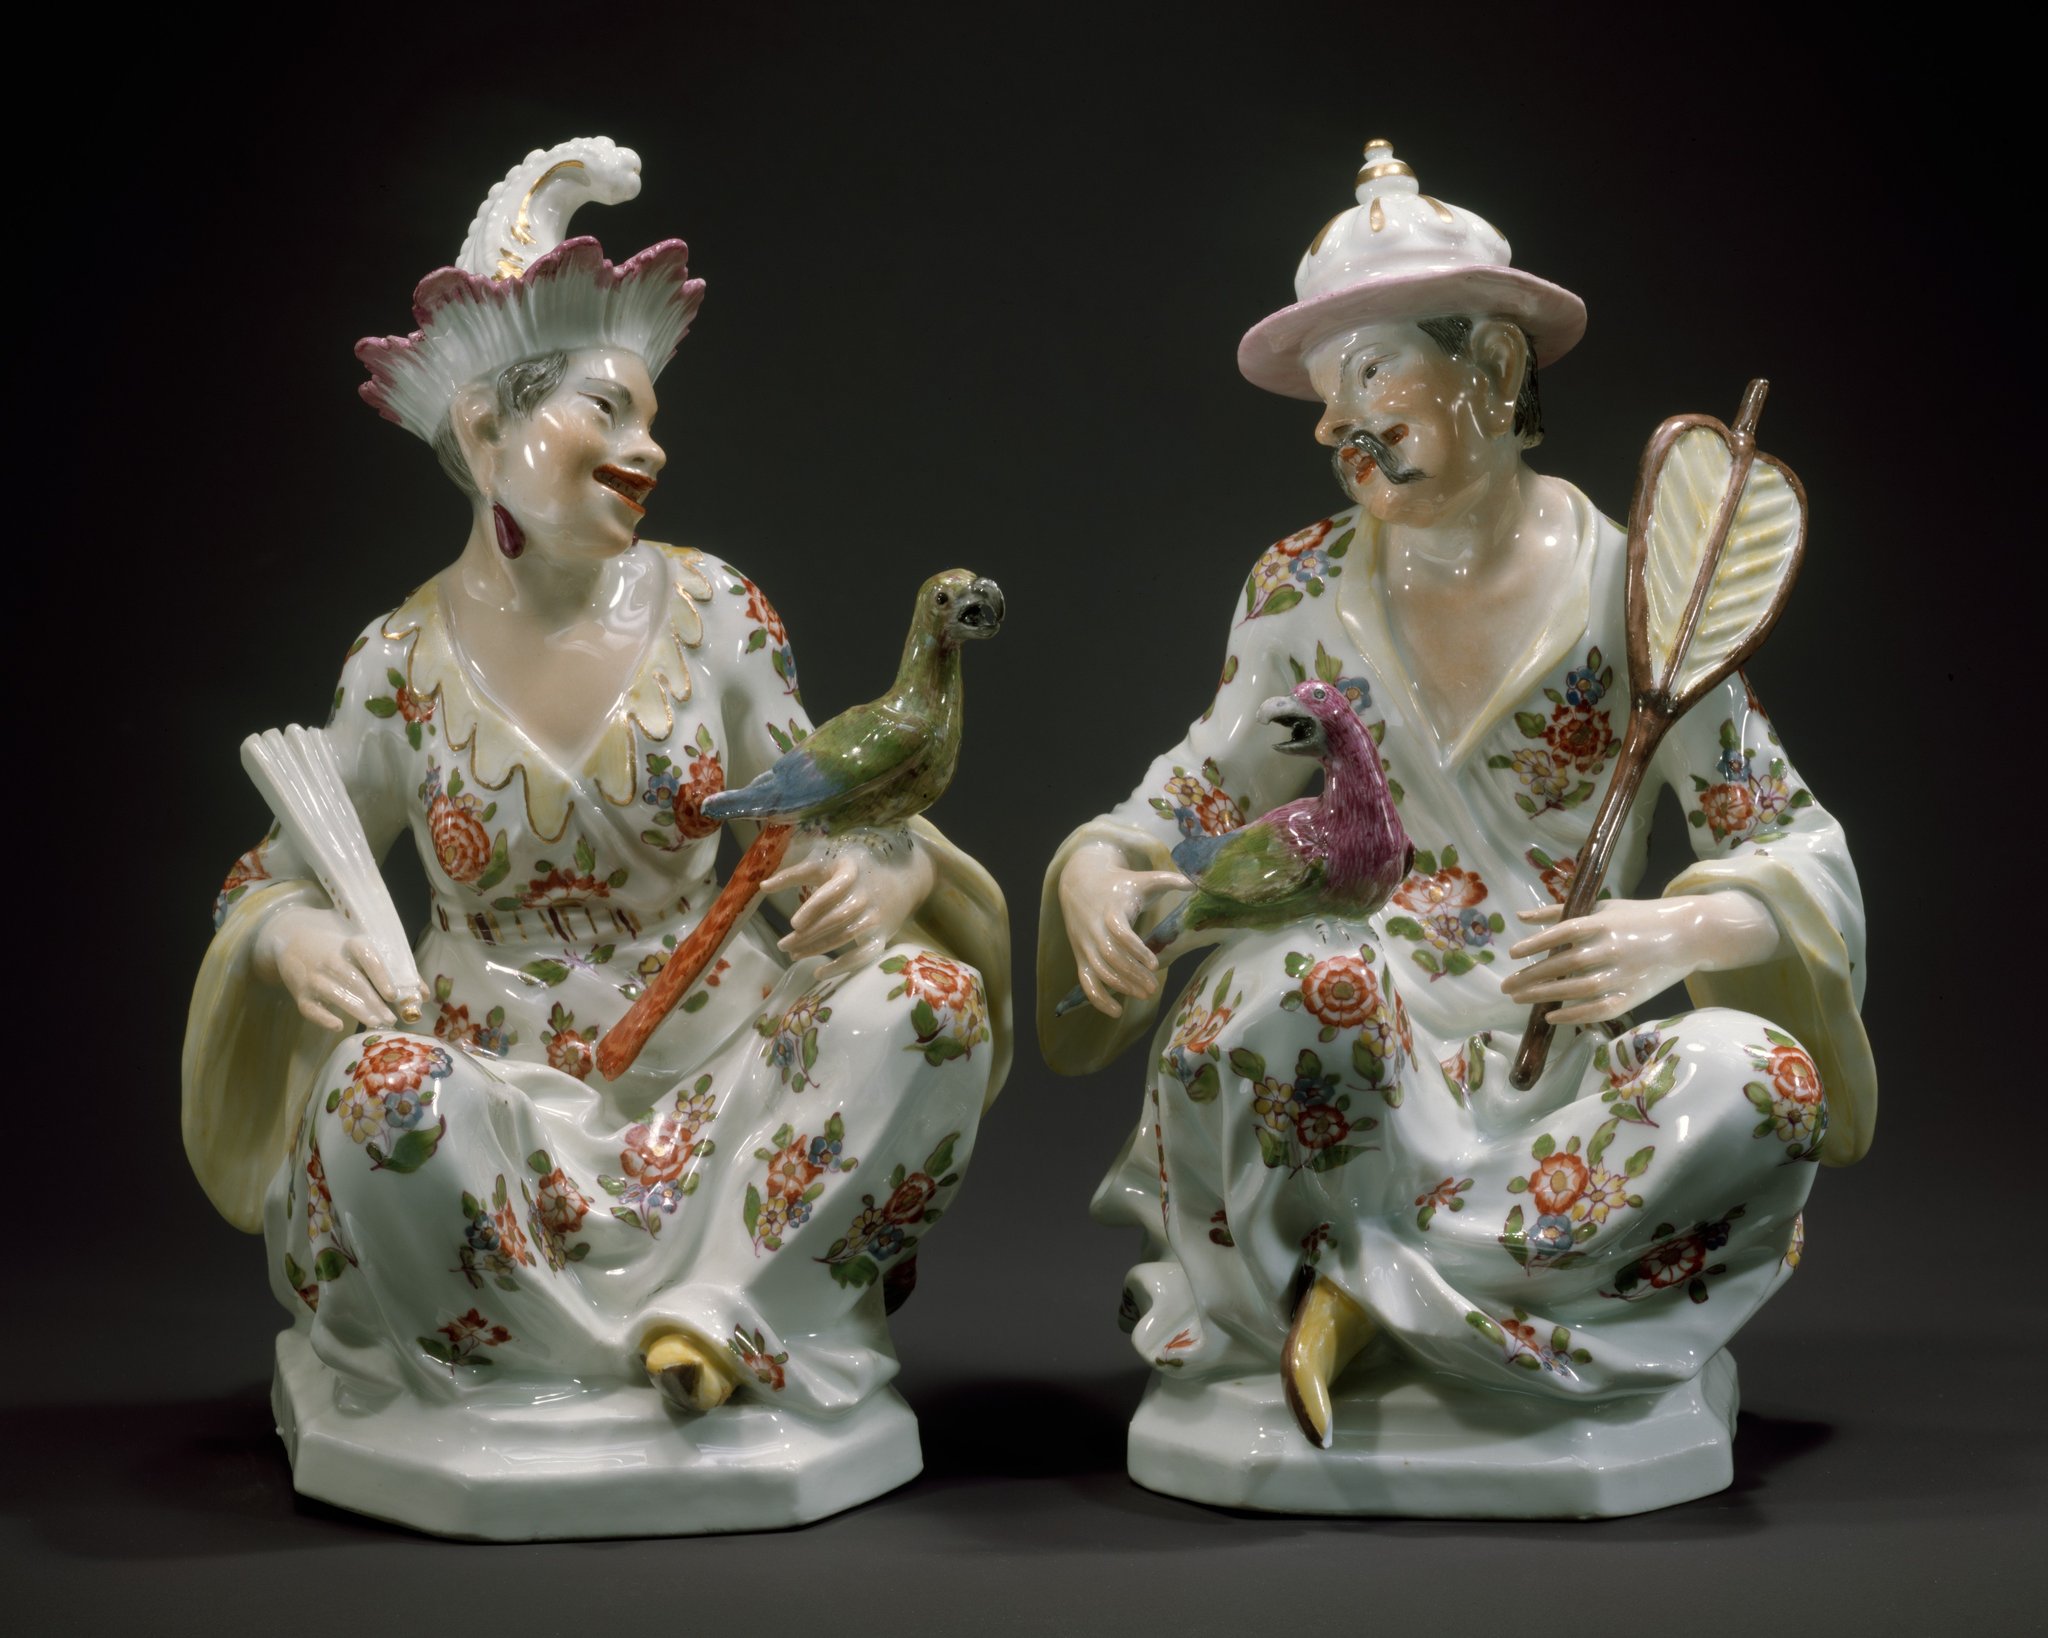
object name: figure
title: Chinese Couple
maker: meissen manufactory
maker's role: manufactory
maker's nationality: german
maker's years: 1710-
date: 1737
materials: hard paste porcelain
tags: birds,couples,men,women